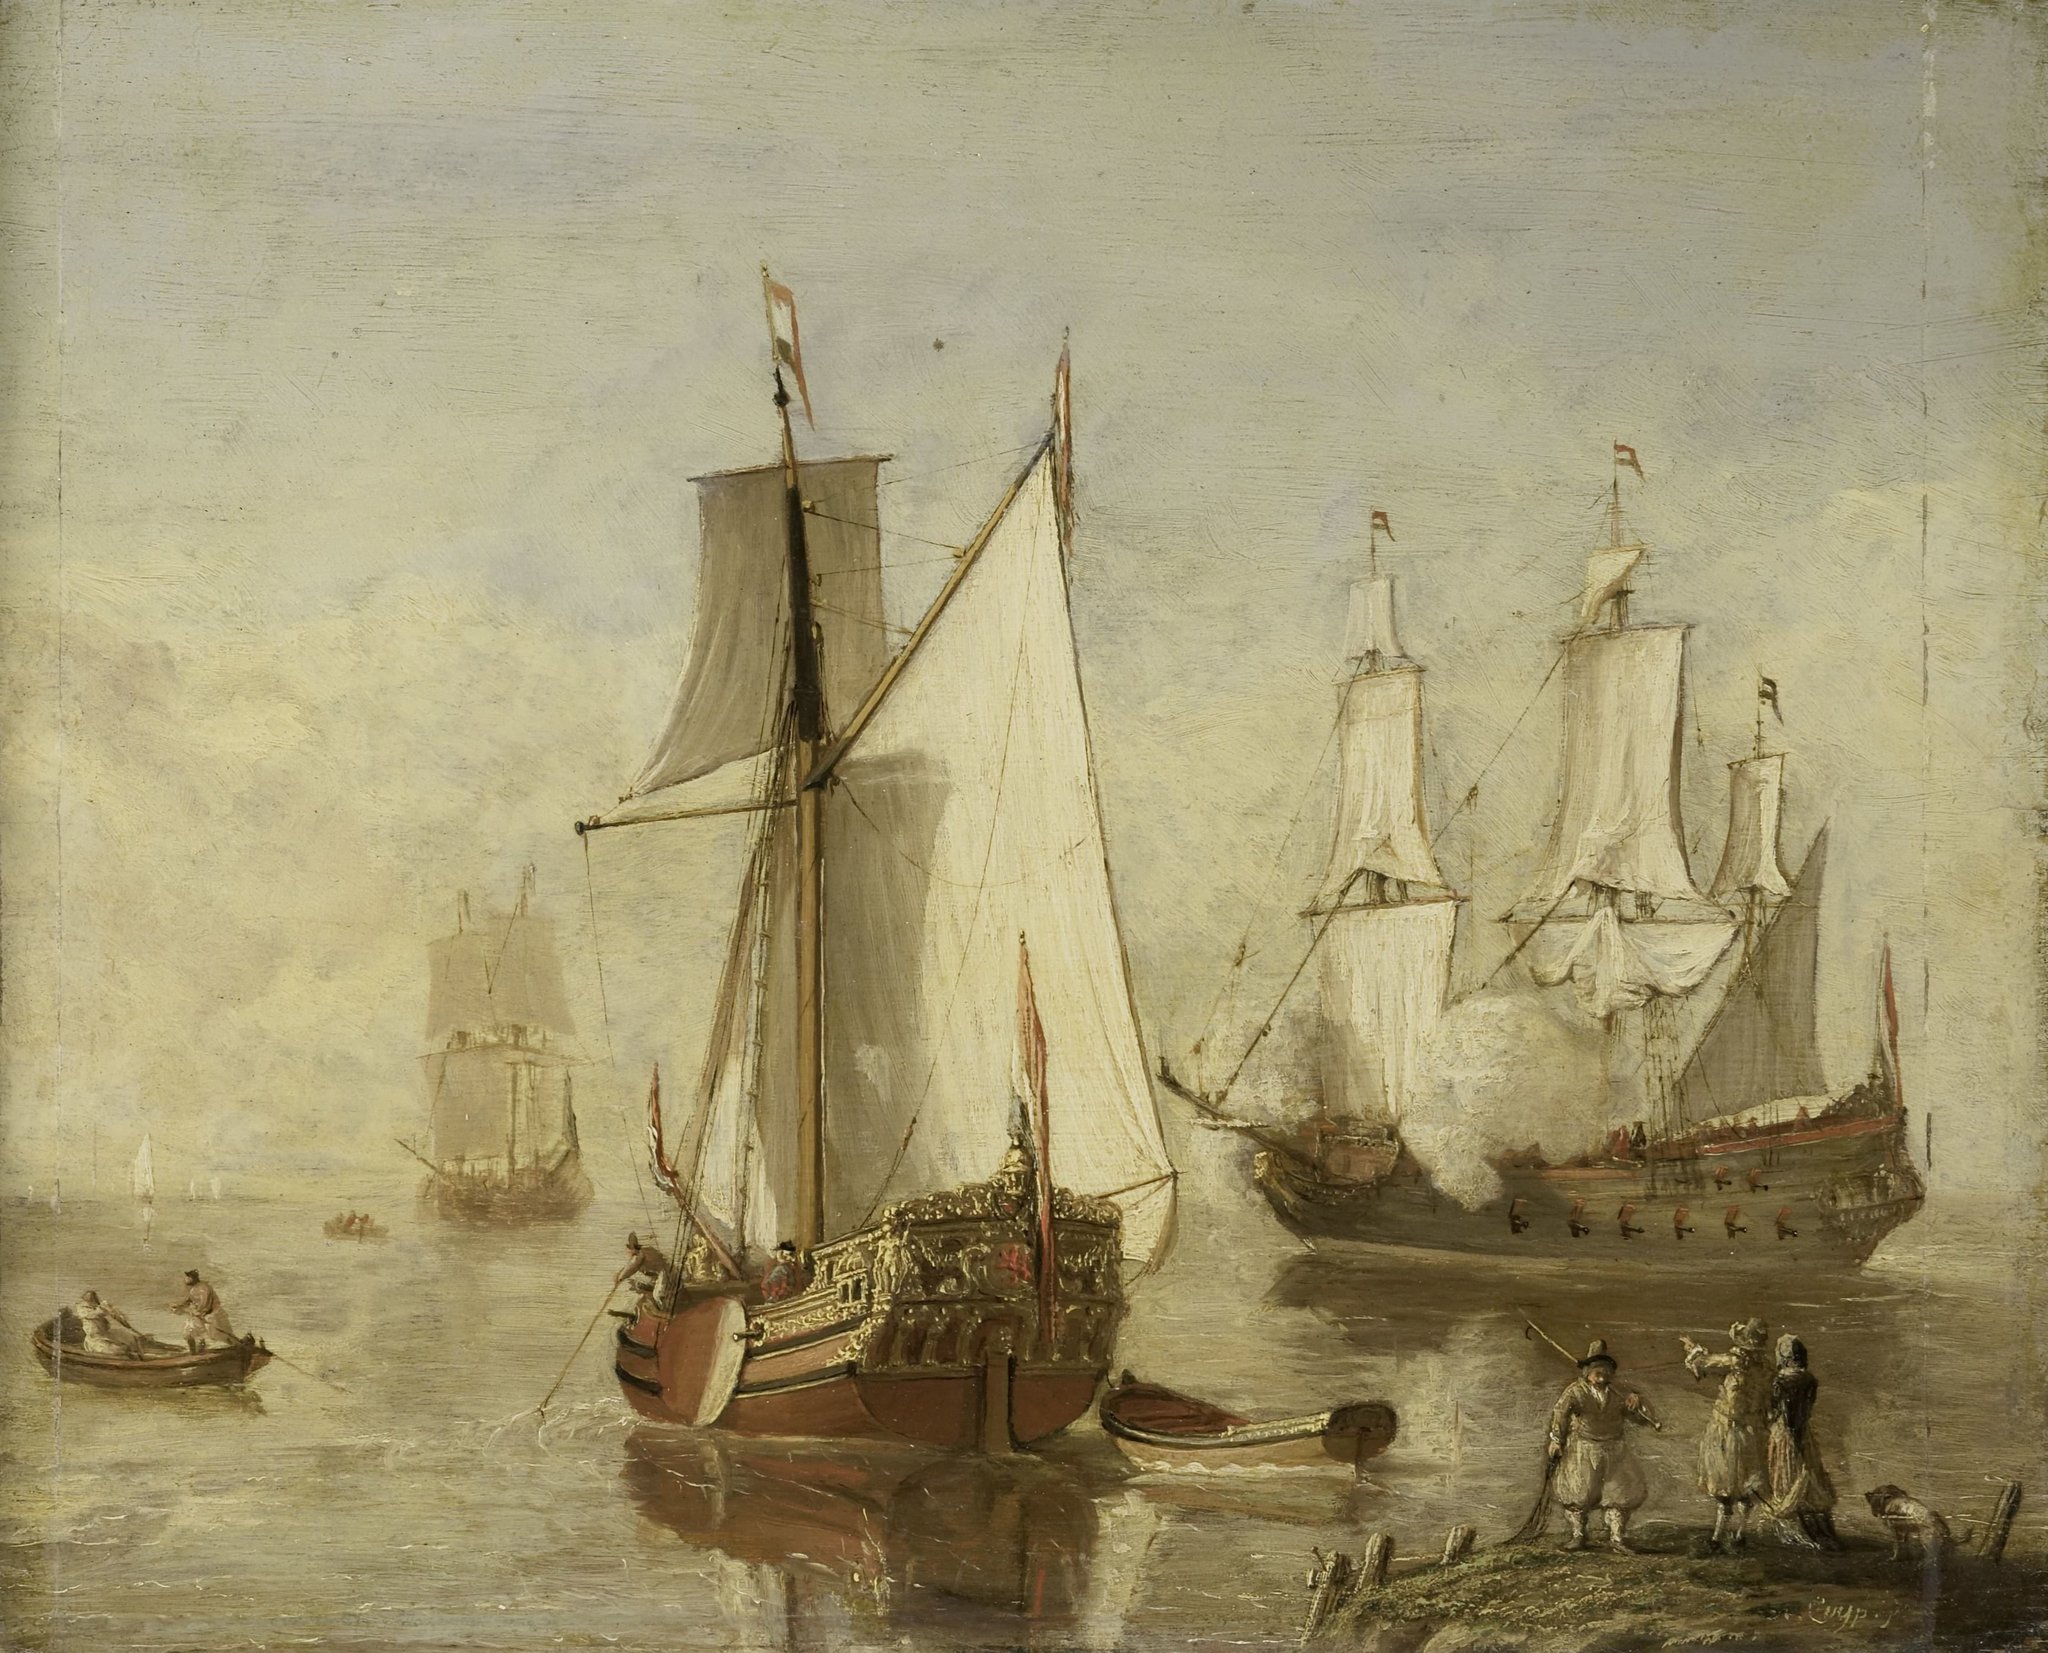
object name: painting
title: Speeljacht (Pleasure Yacht) and Warship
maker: Anonymous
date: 1675-1699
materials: oil, panel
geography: netherlands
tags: sailing-ship, sailing-boat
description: Een speeljacht, een oorlogsschip en enkele andere vaartuigen in het water nabij de kust. Het fegat vuurt een schot. Op de voorgrond staan enkele figuren aan de wal. Imitatie in de stijl van Jan van de Cappelle of Aelbert Cuyp.